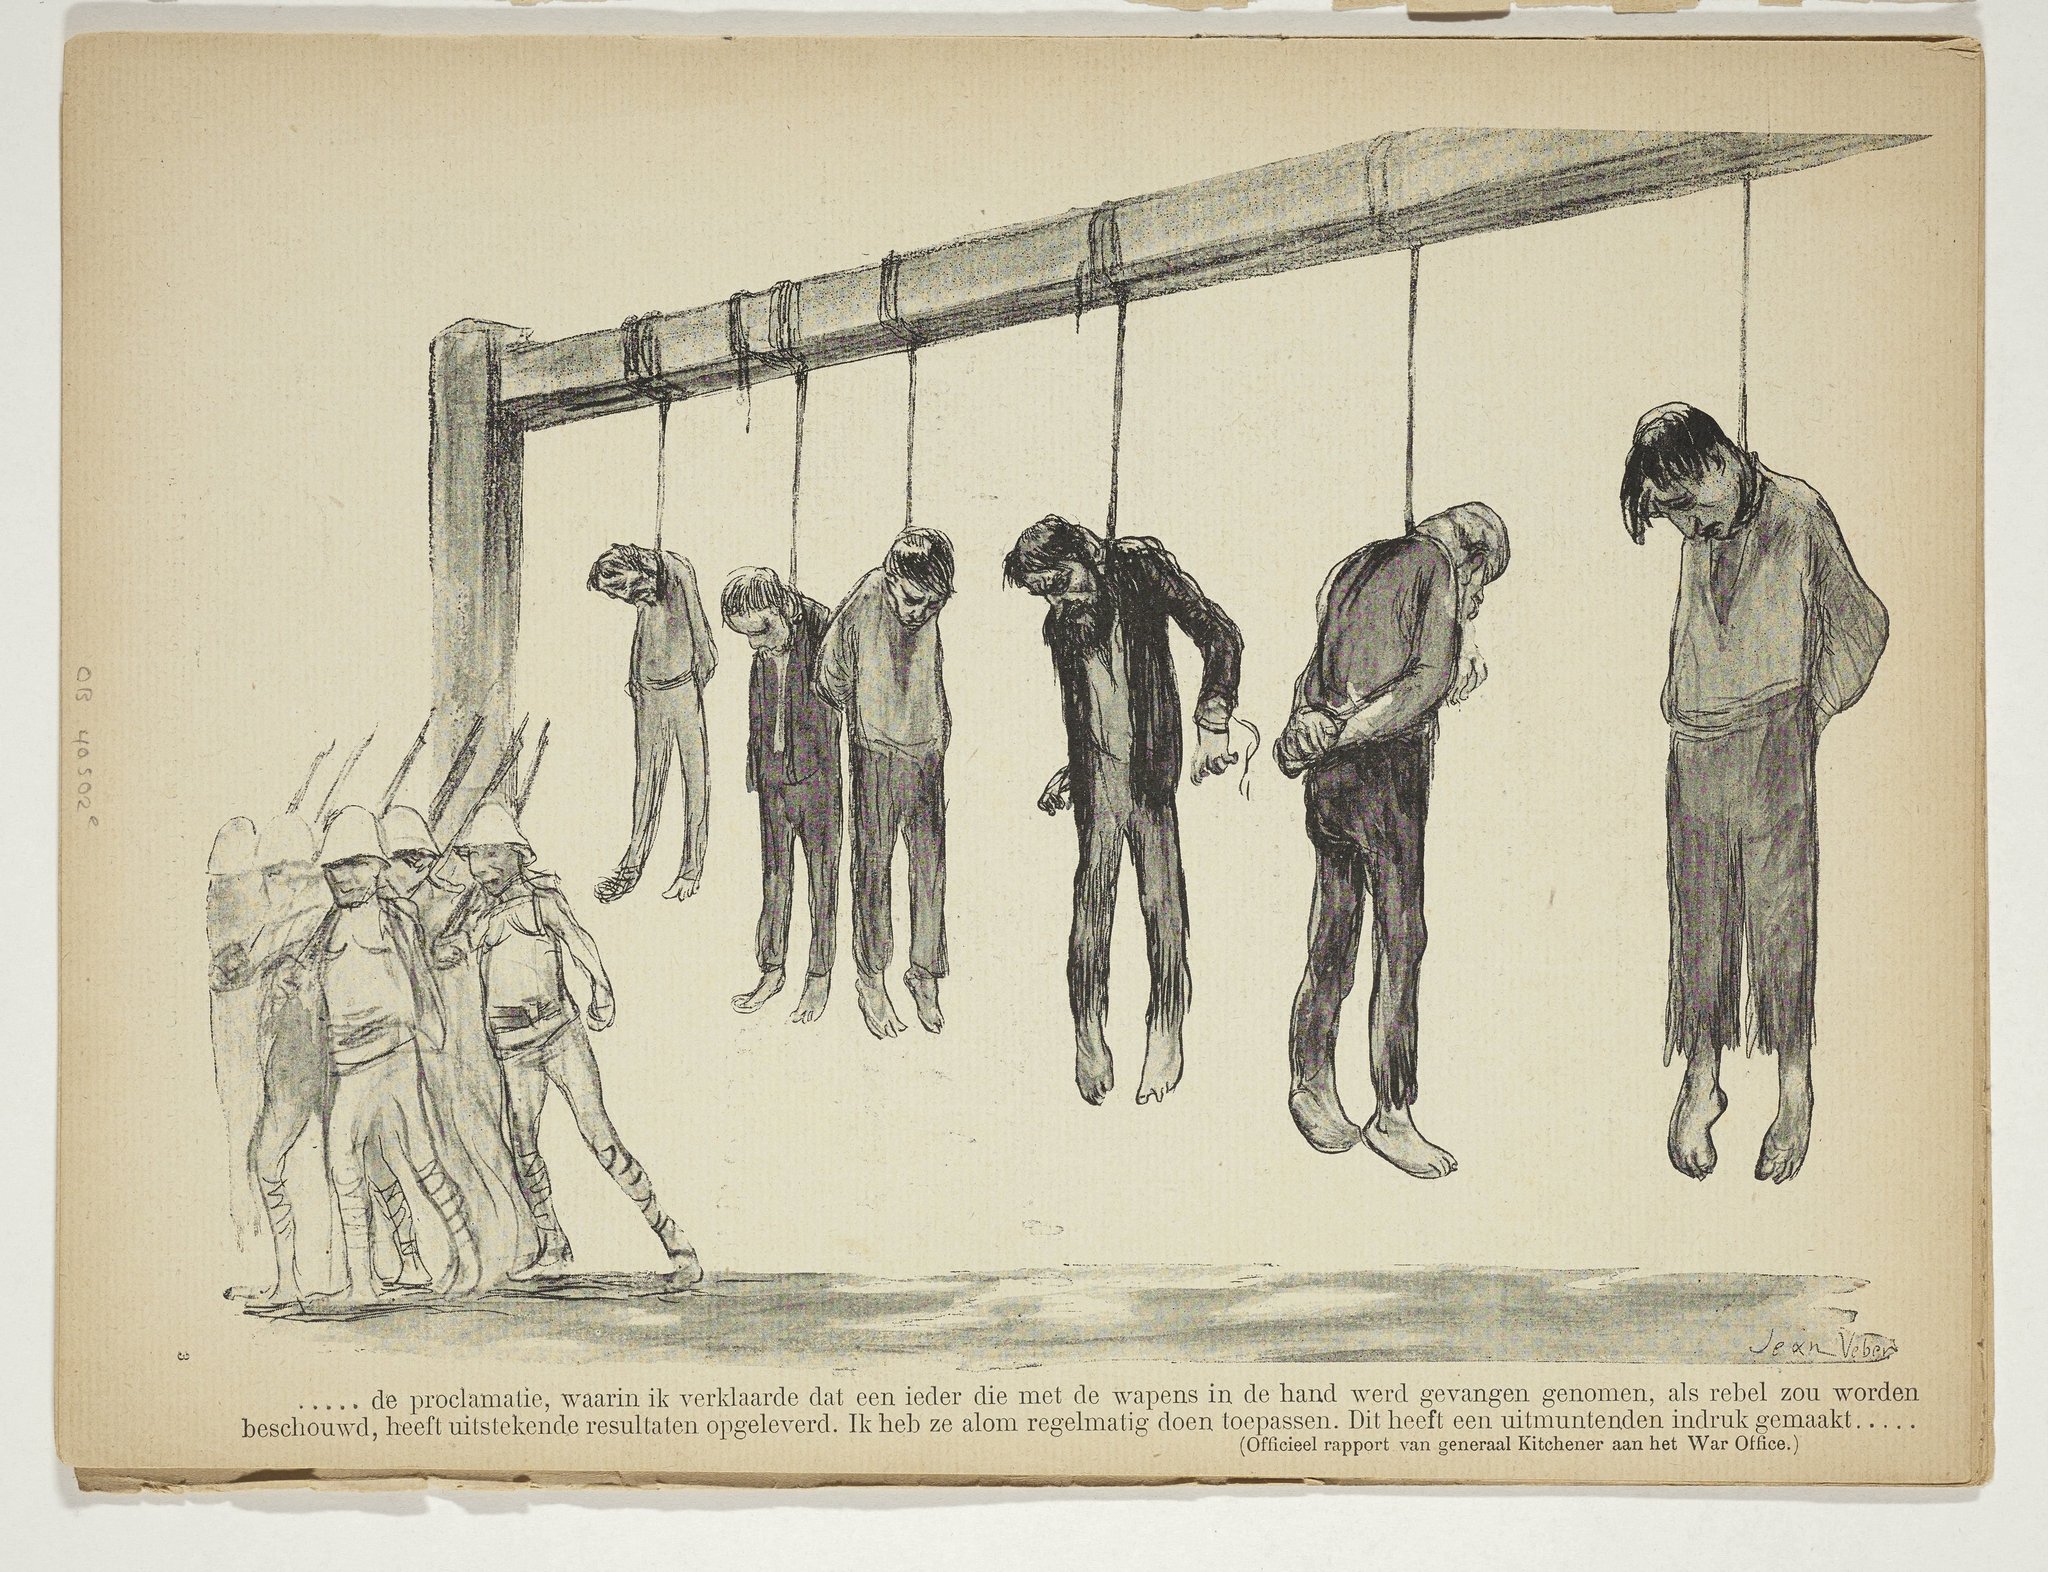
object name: page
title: Door de Britten opgehangen Boeren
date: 1901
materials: paper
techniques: letterpress printing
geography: amsterdam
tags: violent death by hanging, the soldier; the soldier's life, political caricatures and satires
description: Prent maakt deel uit van een tijdschrift met spotprenten op de Tweede Boerenoorlog. Met drieregelig onderschrift: ..... de proclamatie, waarin ik verklaarde dat een ieder die met wapens in de hand ... (Officieel rapport van generaal Kitchener aan het War Office.).